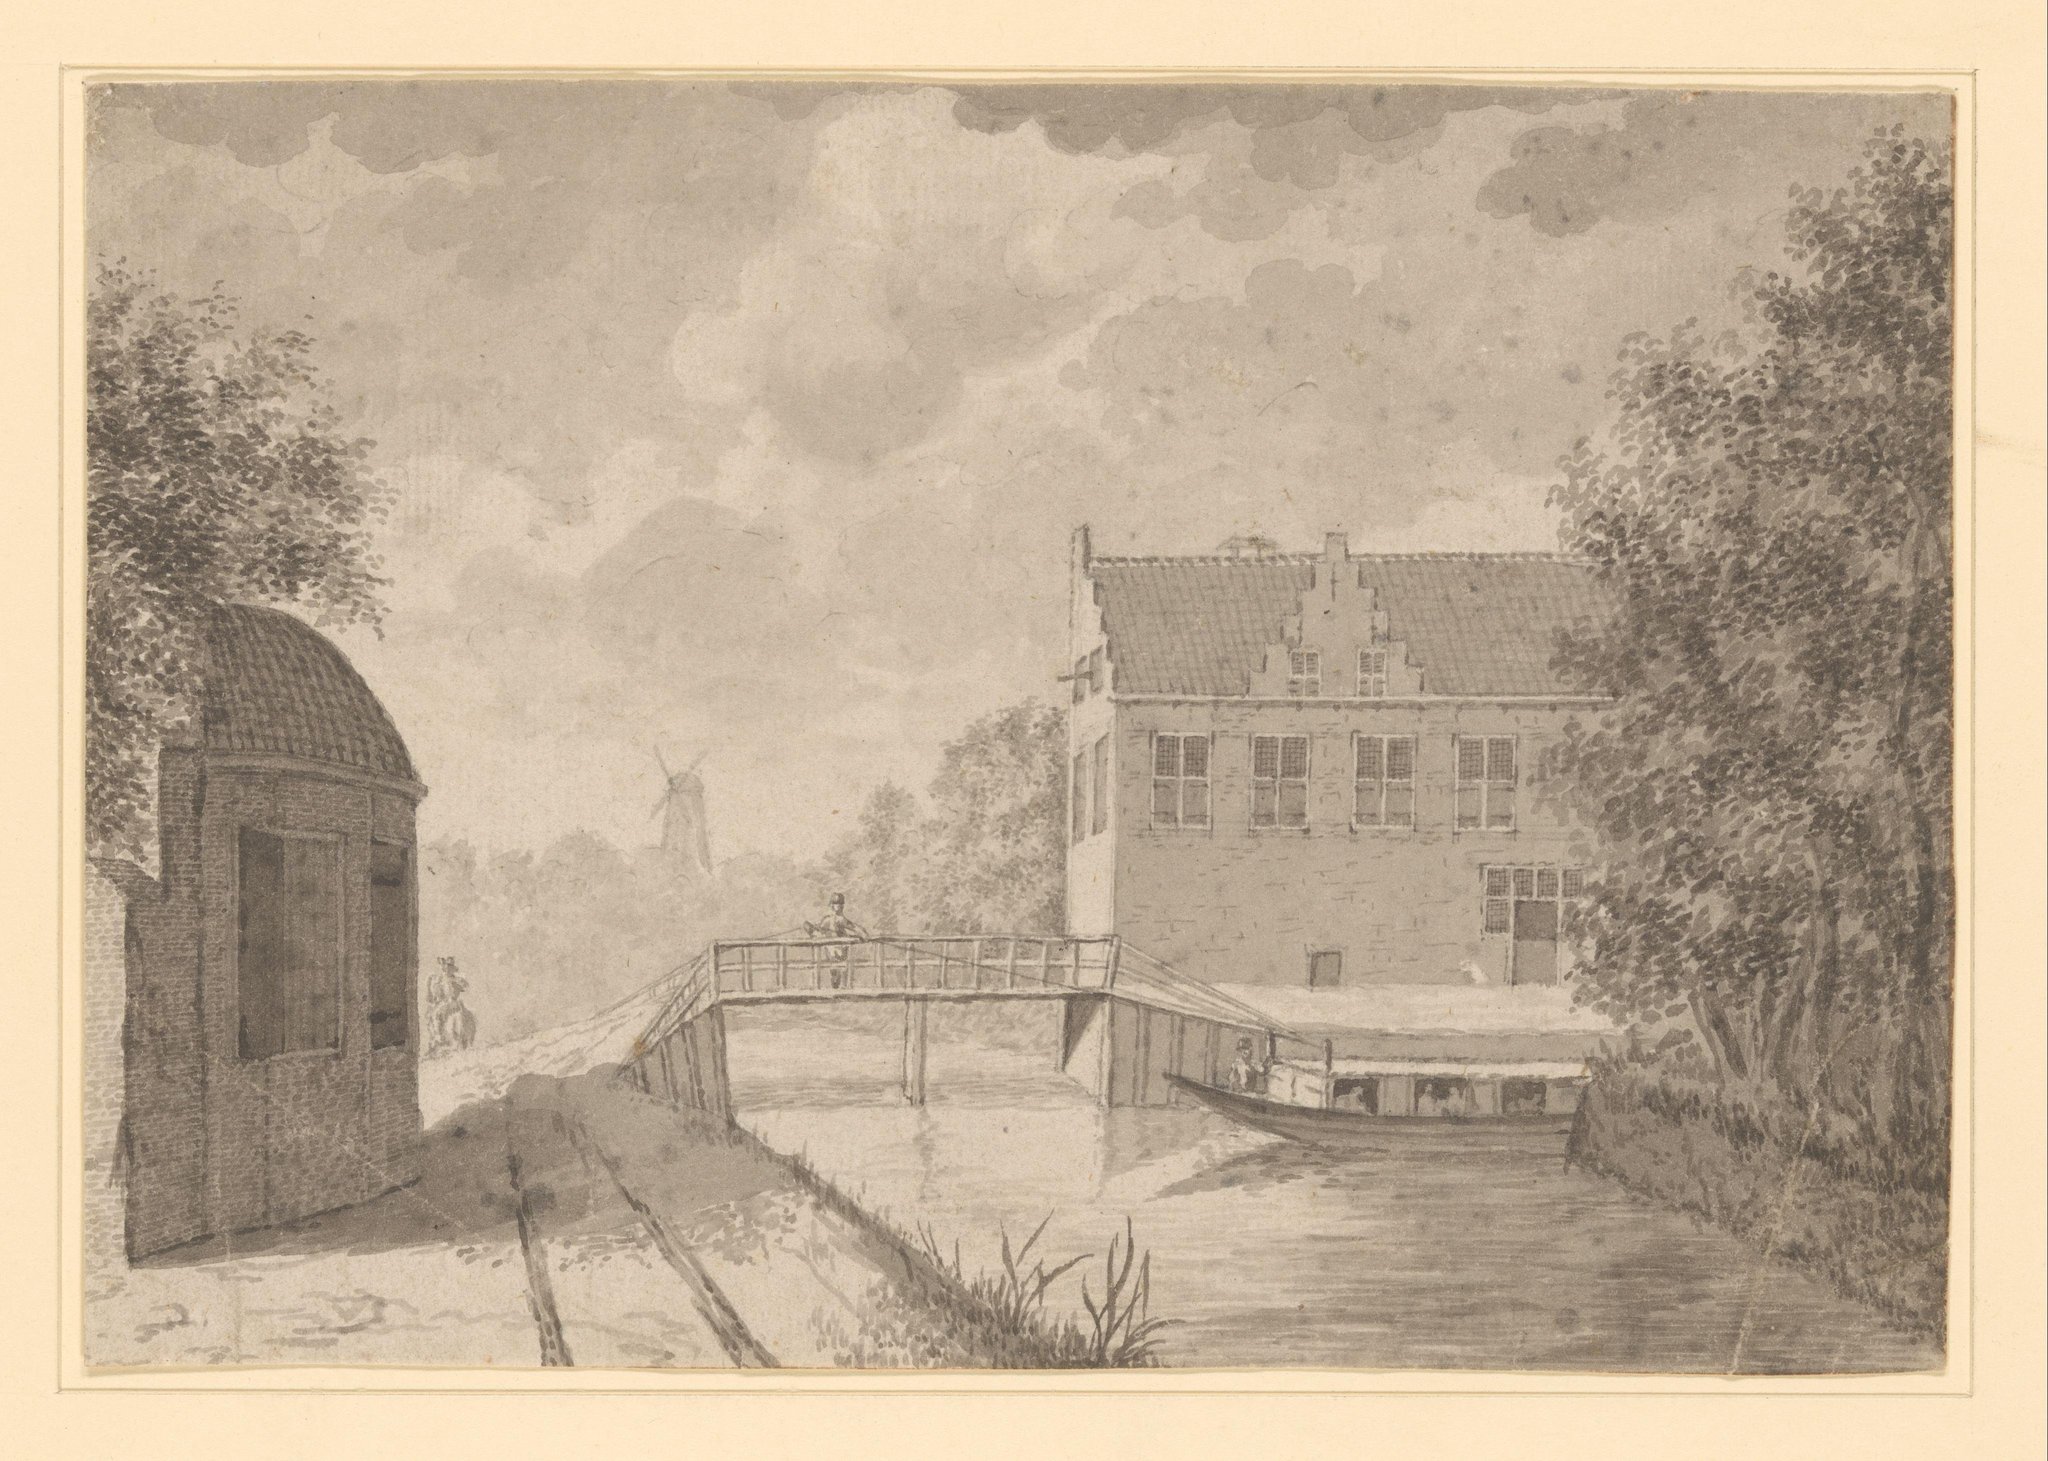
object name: drawing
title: Gezicht op een brug over de trekvaart tussen Leiden en Den Haag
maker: Anonymous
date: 1750-1850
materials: ink, paper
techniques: brush, pen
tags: windmill, bridge in village across river, canal, etc.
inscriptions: collector's mark: Lugt 2228